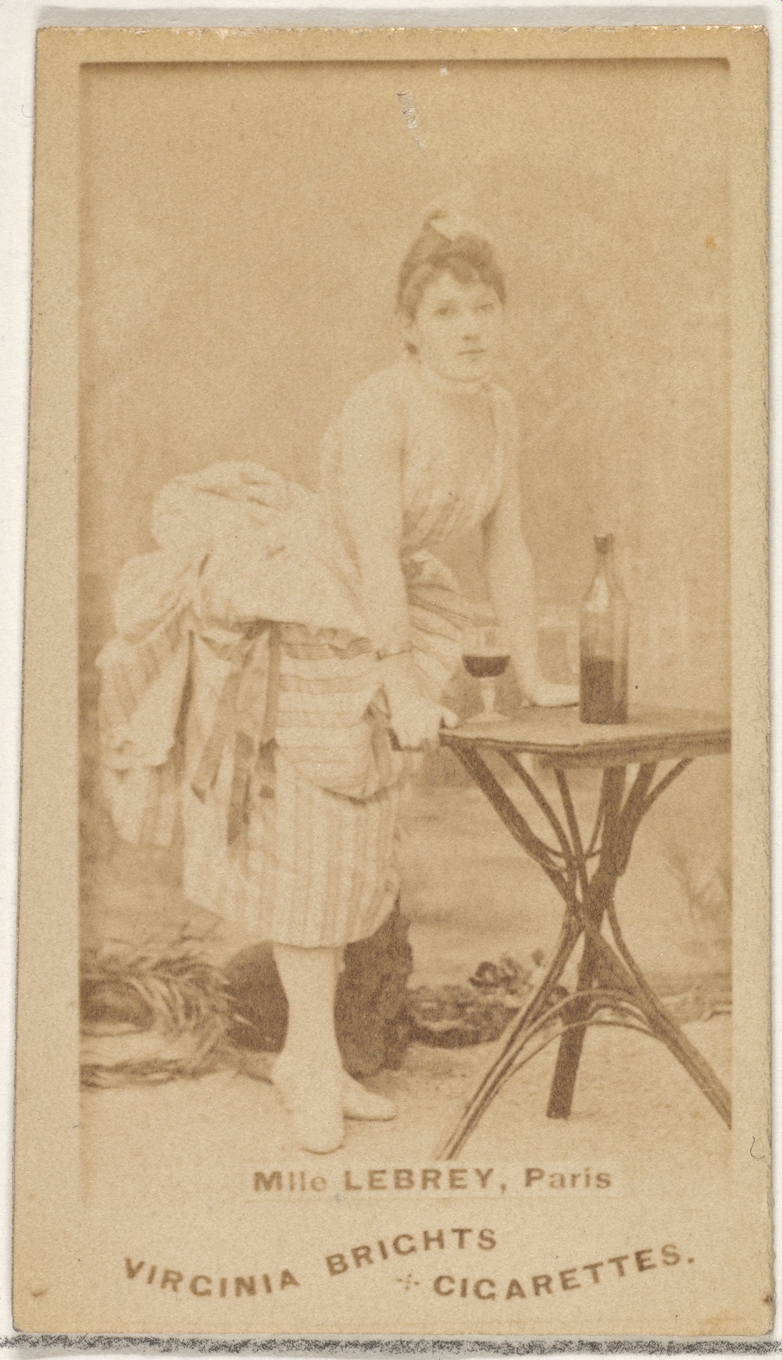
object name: photograph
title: Mlle. Lebrey, Paris, from the Actors and Actresses series (N45, Type 1) for Virginia Brights Cigarettes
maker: allen & ginter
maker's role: publisher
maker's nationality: american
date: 1888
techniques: albumen silver print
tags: portraits,women,actresses